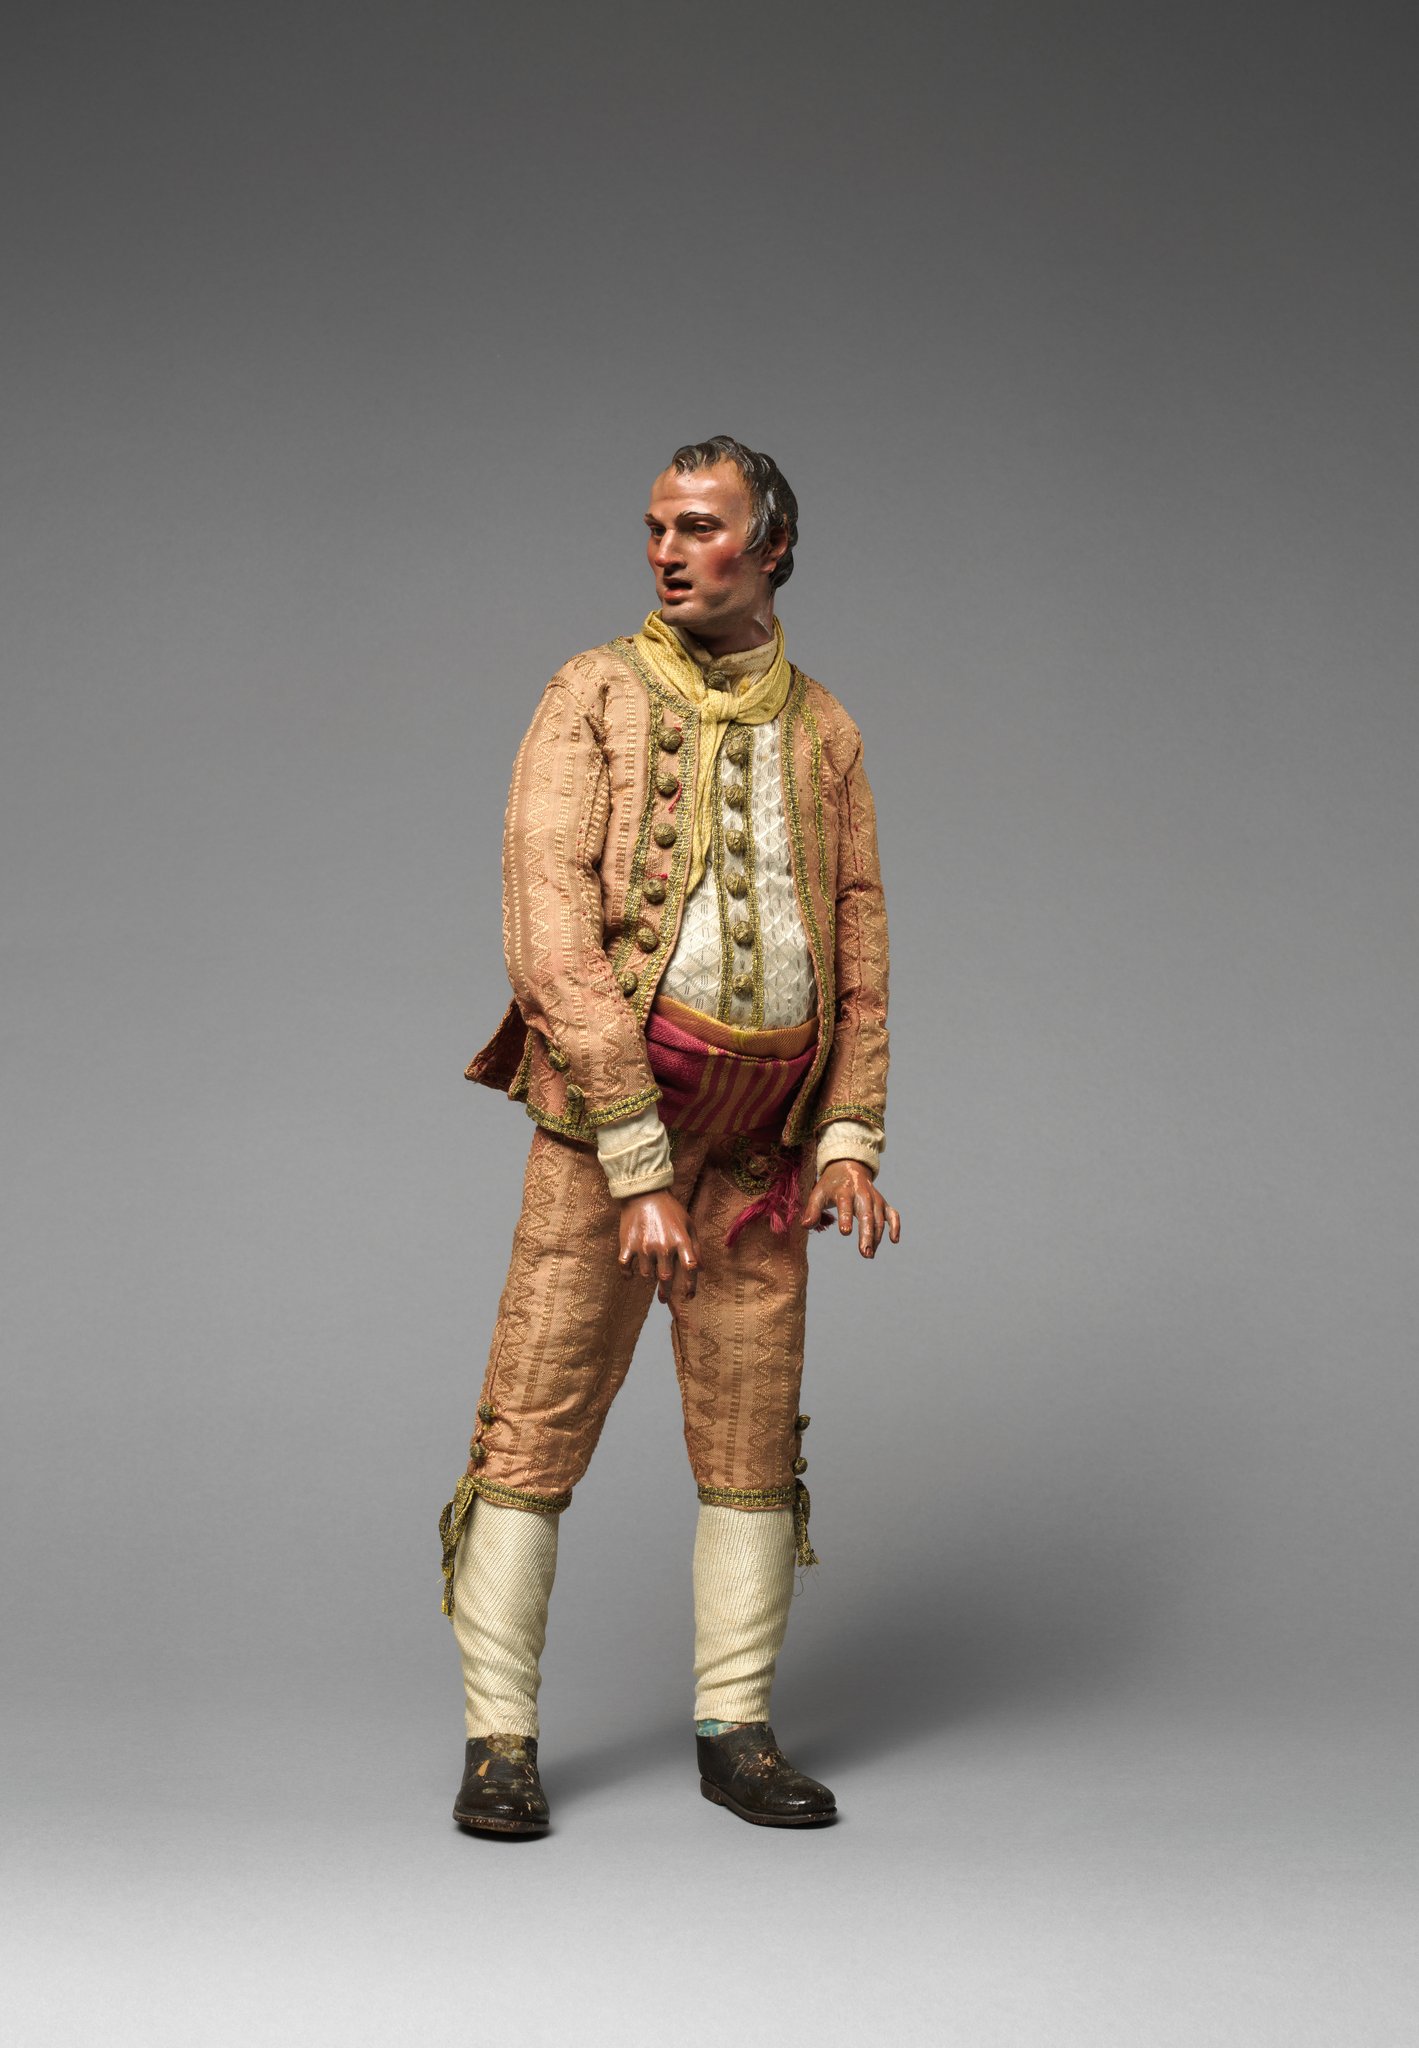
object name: crèche figure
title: Gentleman with pot belly in salmon colored outfit with buttons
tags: men